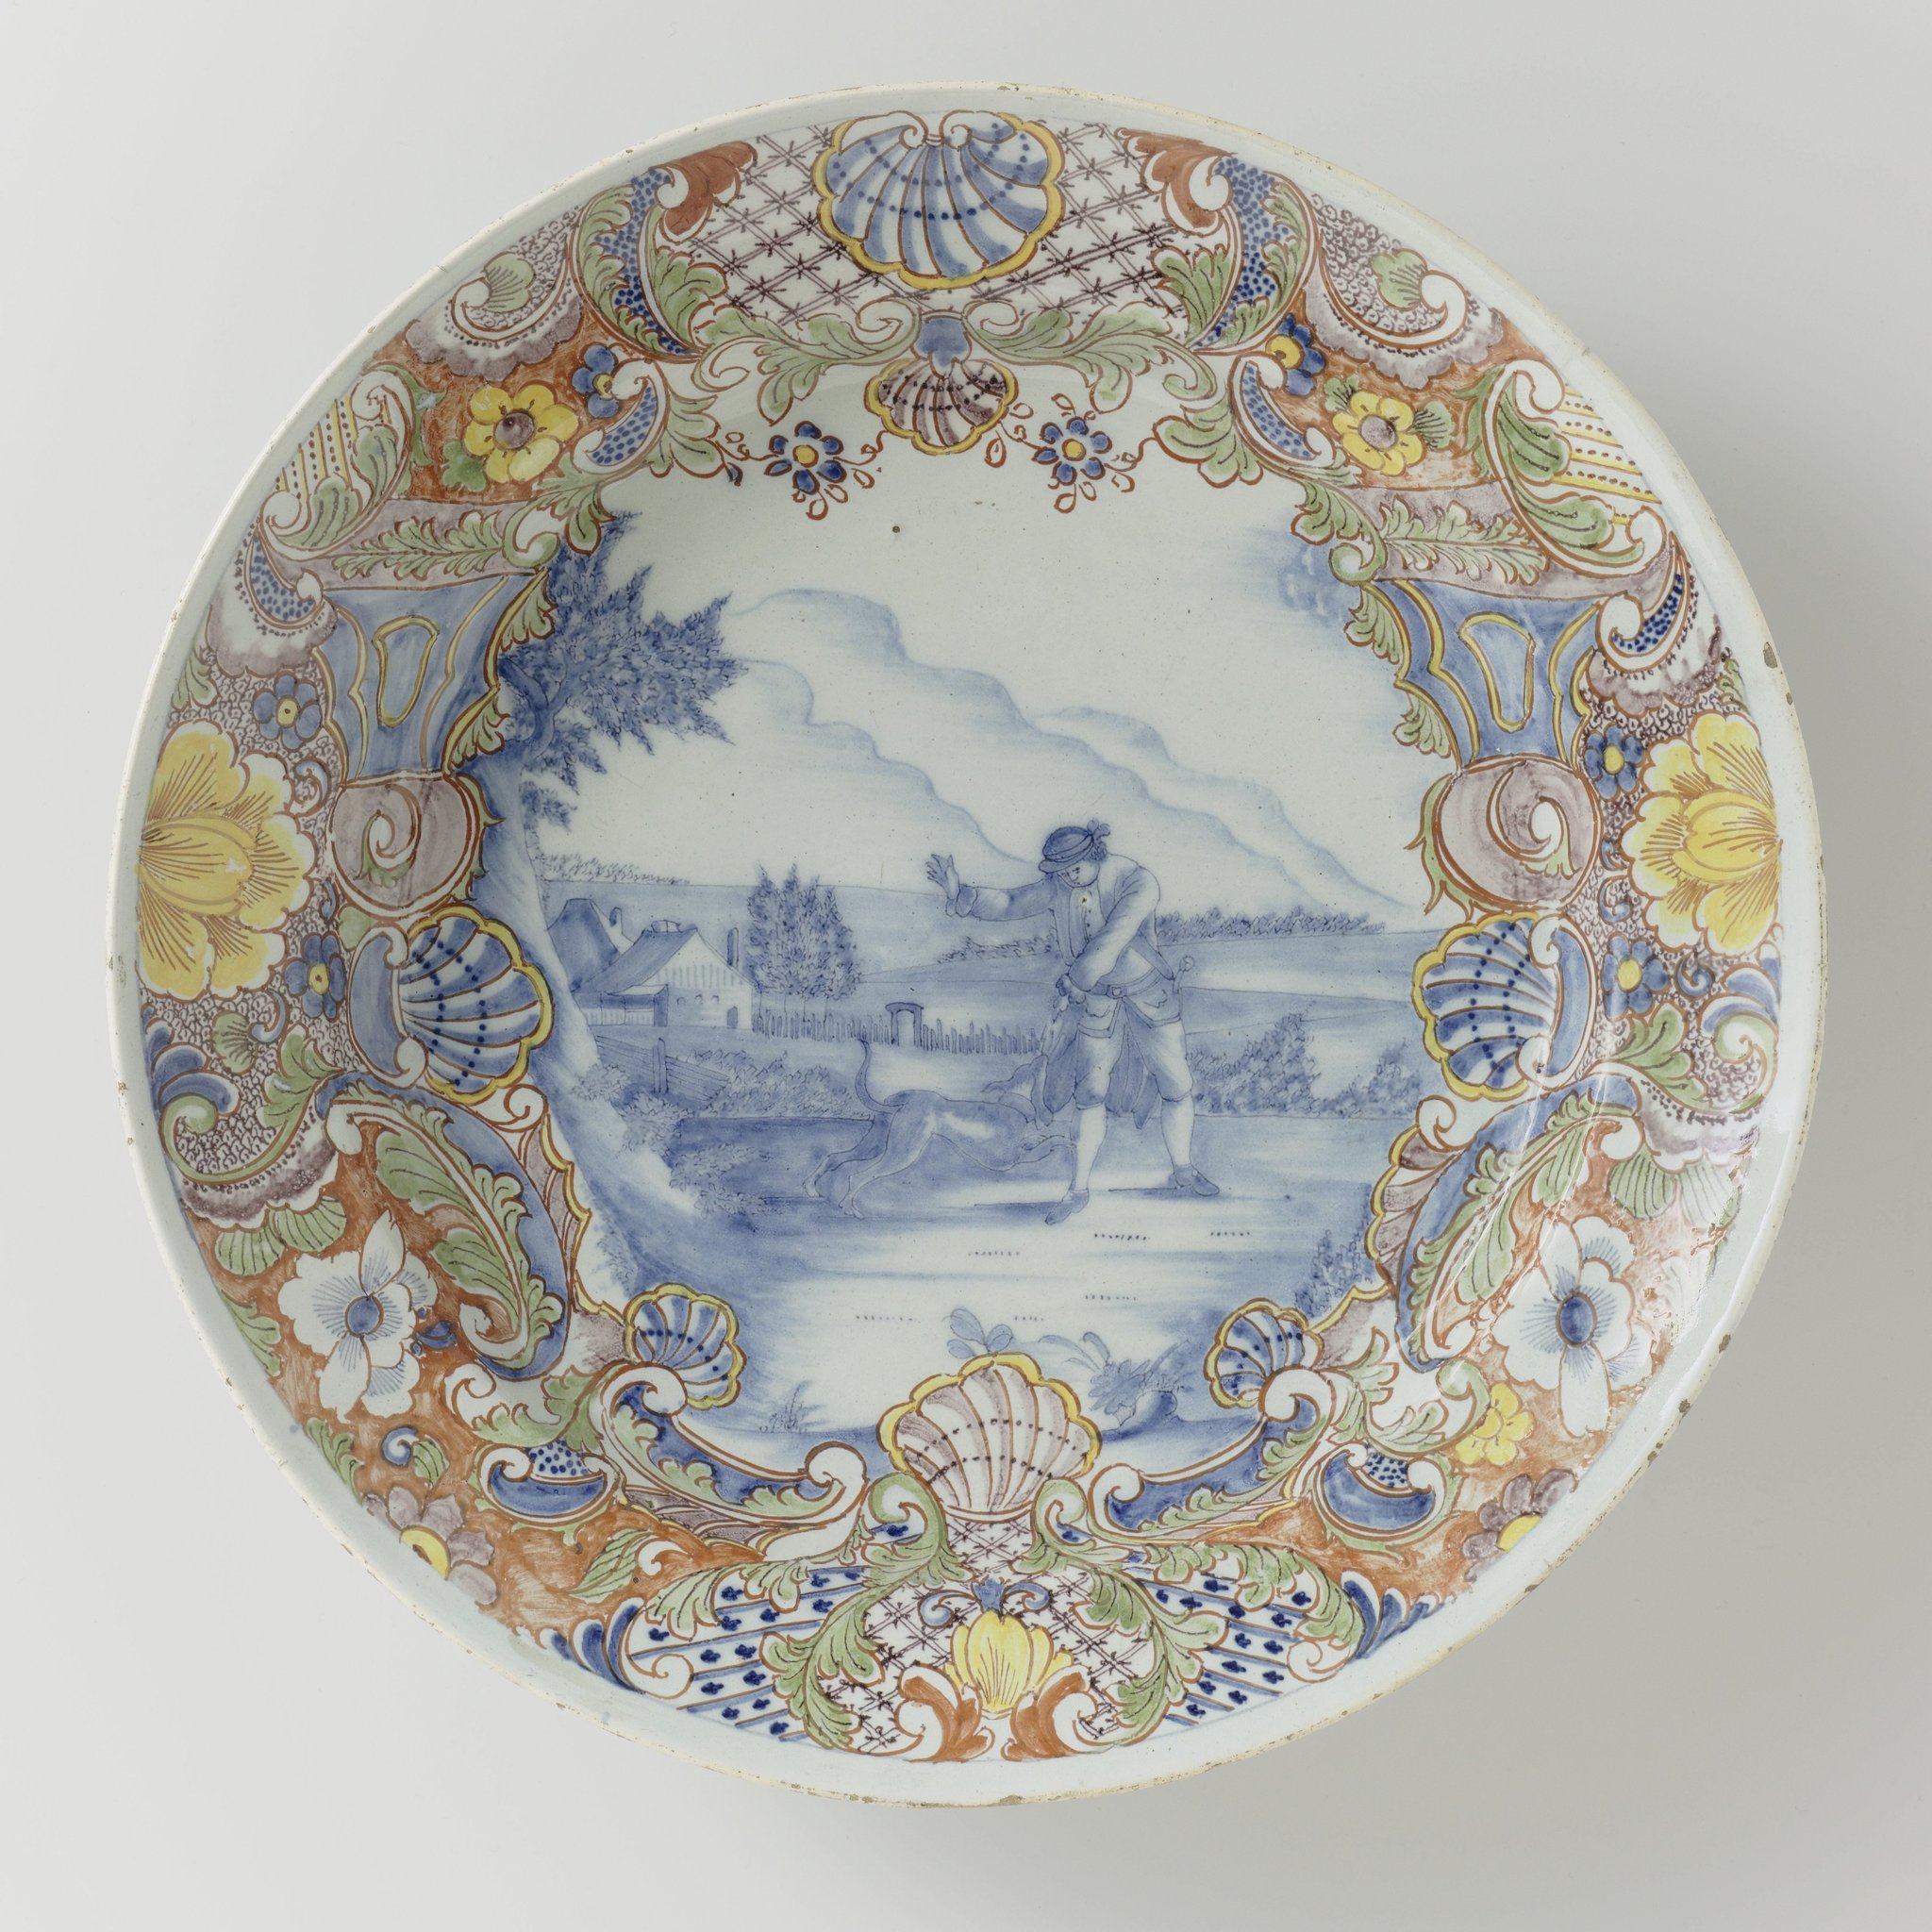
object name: platter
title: Schotel van faïence met landschap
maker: Anonymous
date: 1740-1775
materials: faience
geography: delft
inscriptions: collector's mark: ‘collection J.F. Loudon’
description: Schotel van faïence. Blauw beschilderd met een landschap. De brede rand is veelkleurig beschilderd.